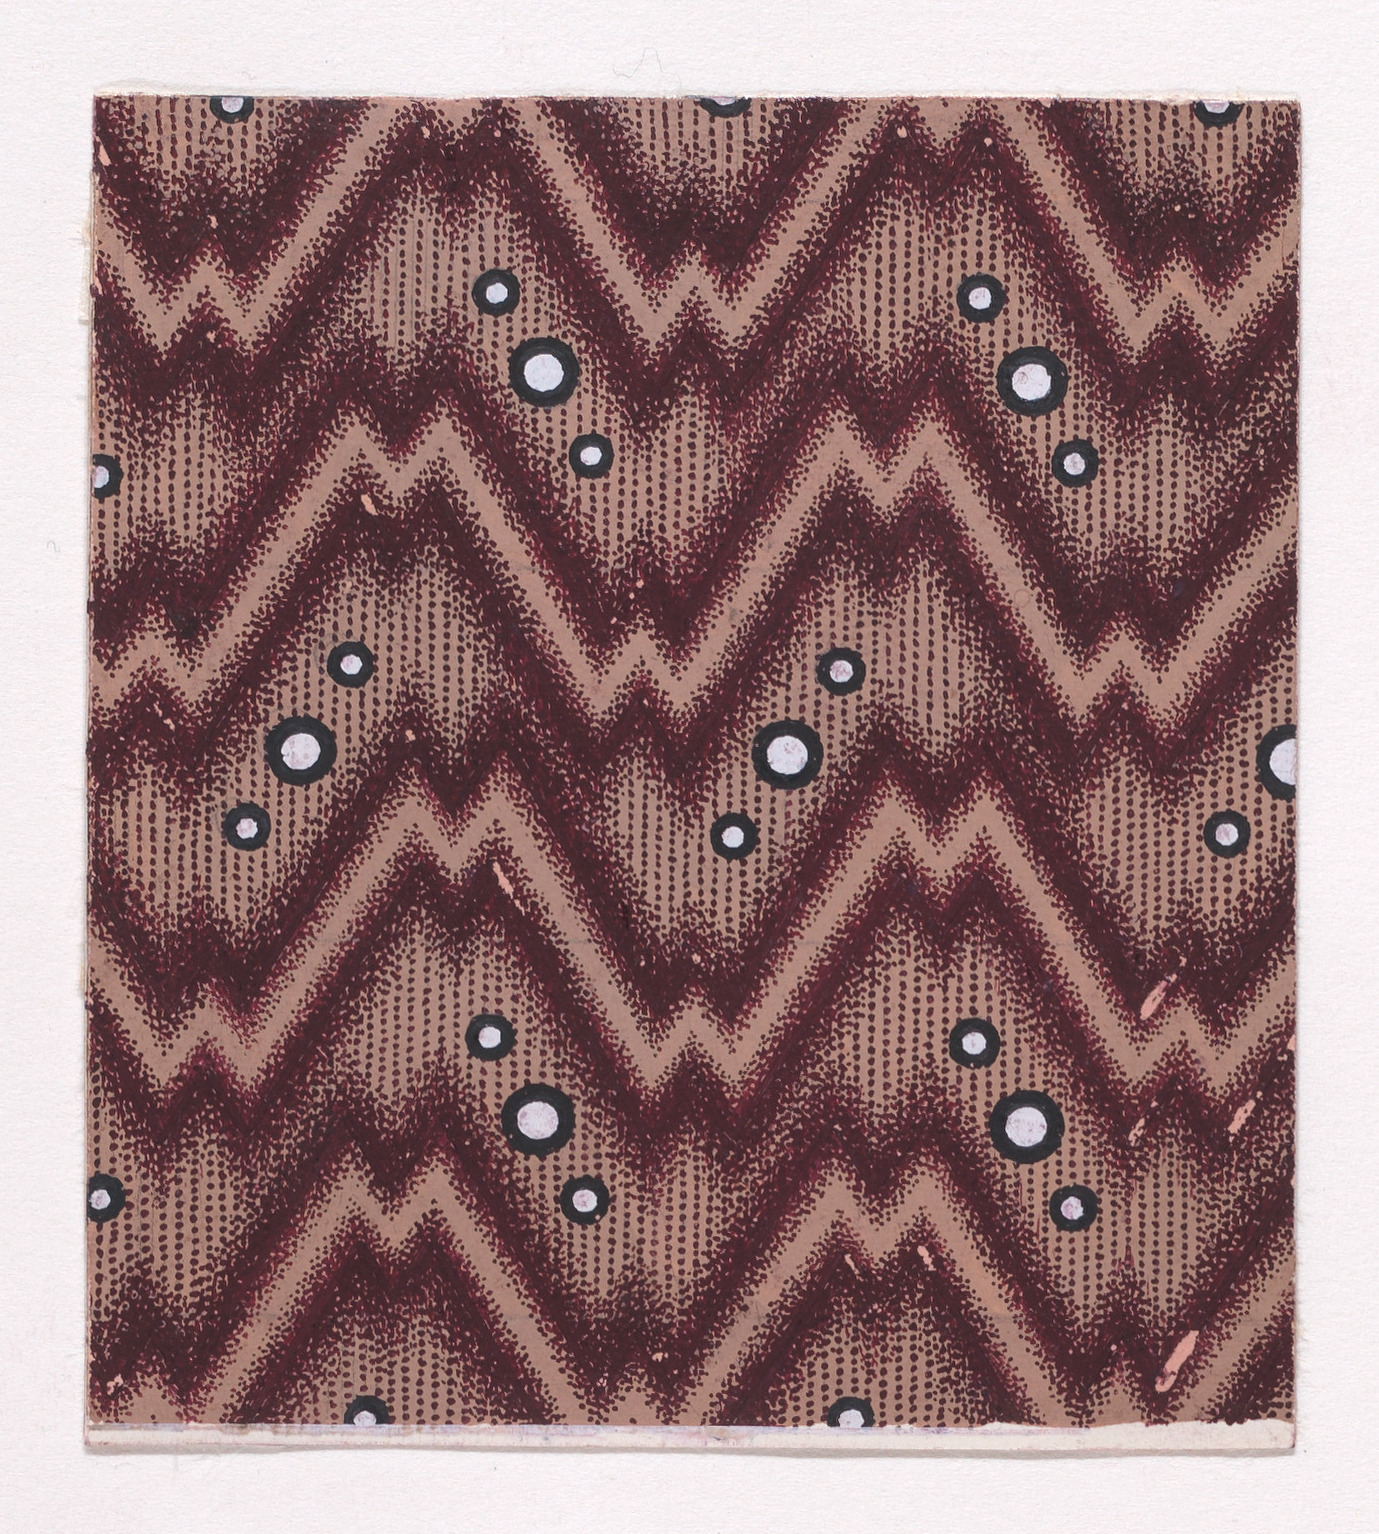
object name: drawing ornament architecture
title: Textile Design of Horizontal Zig-Zagging Ribbons and Alternating Diagonal Groups of Three Pearls over a Striped Background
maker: anonymous, alsatian, 19th century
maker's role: artist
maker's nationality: alsatian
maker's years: 1800-1900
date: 1840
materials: gouache